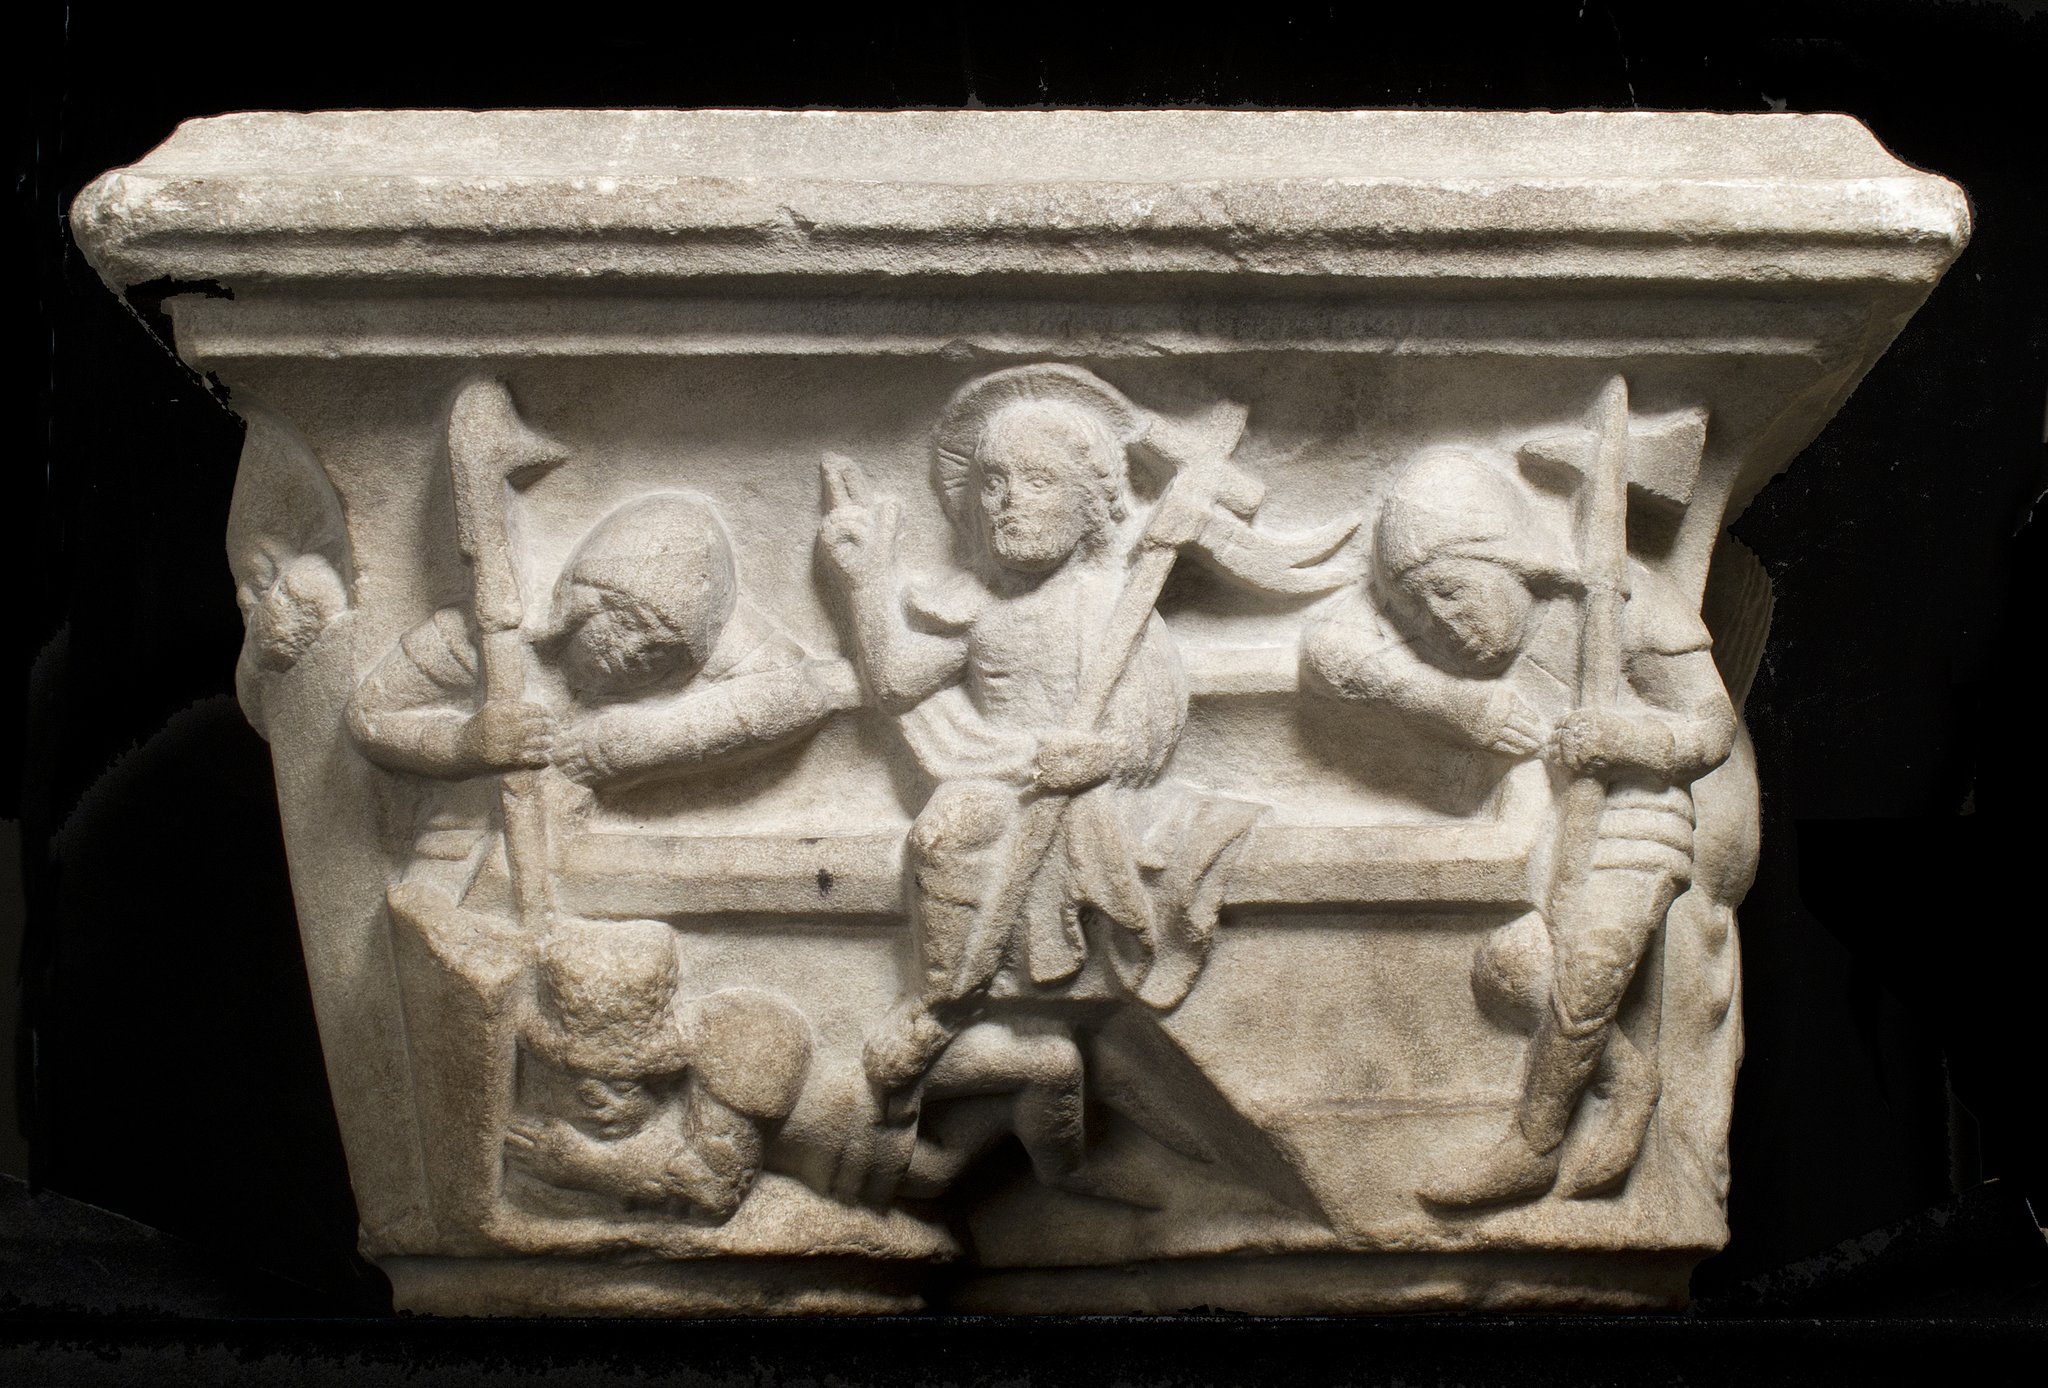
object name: capital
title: Double Capital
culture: french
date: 1480-1500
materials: marble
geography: france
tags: men,christ,resurrection